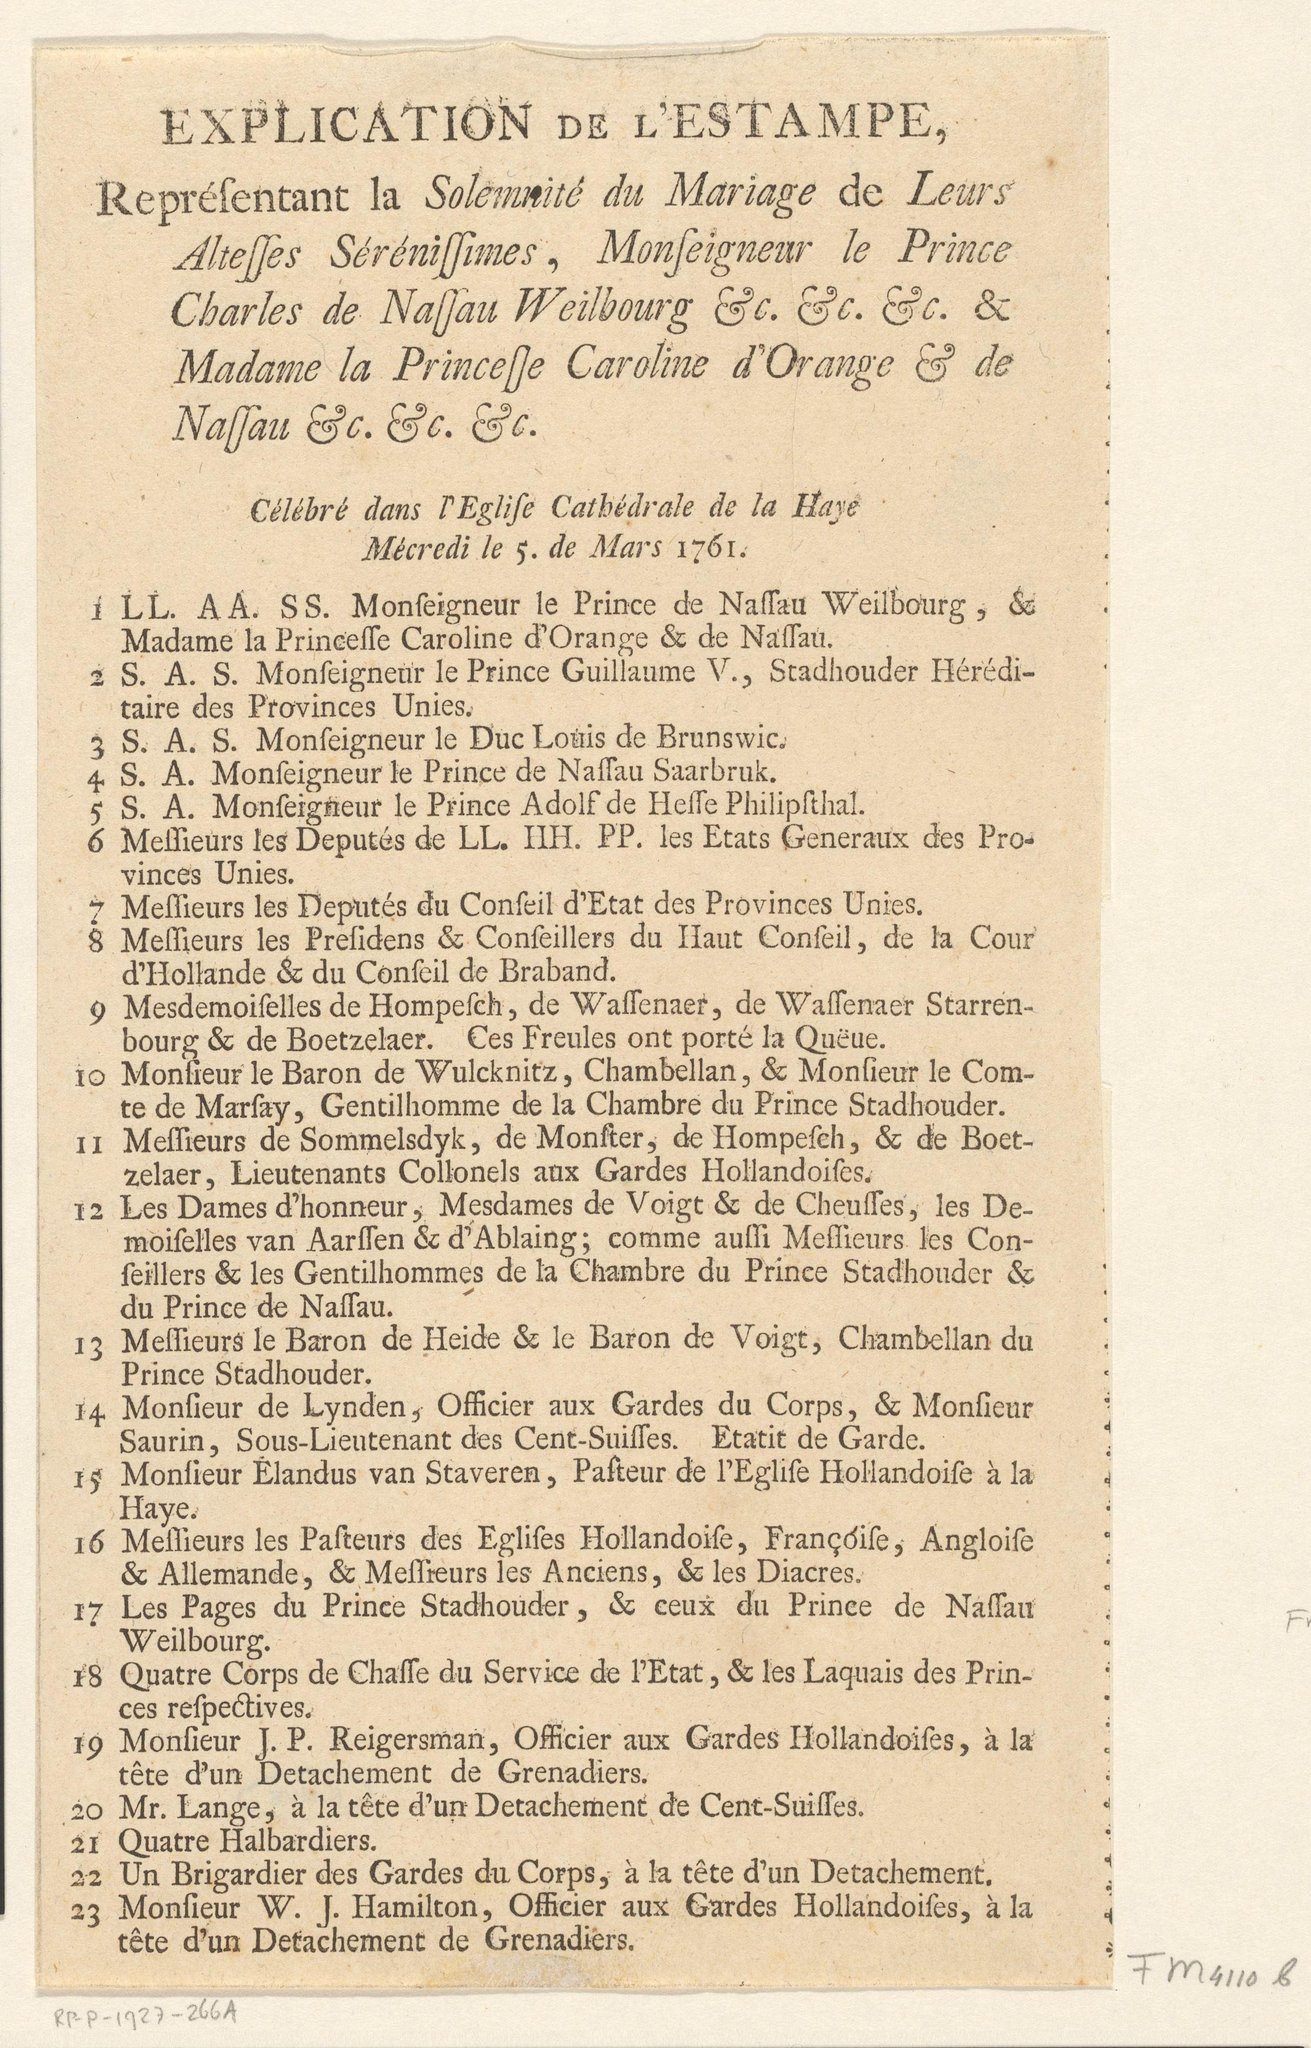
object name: text sheet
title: Explication de l'Estampe, Représentant la Solemnitédu Mariage de Leurs Altesses (...)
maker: pieter gerard van balen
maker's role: bookseller, publisher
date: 1761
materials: paper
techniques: letterpress printing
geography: the hague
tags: the hague, william v (prince of orange), ludwig ernst von braunschweig-wolfenbüttel, carolina (prinses van oranje-nassau), karel christiaan vorst van nassau-weilburg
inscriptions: collector's mark: Lugt 2166, collector's mark: Lugt 2228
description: De helft van het tekstblad behorend bij de prent van de huwelijksceremonie van Karel Christiaan van Nassau-Weilburg met prinses Carolina, 5 maart 1760. Alleen de verklaring van de cijfers 1-23 in het Frans, zonder het deel in het Nederlands.